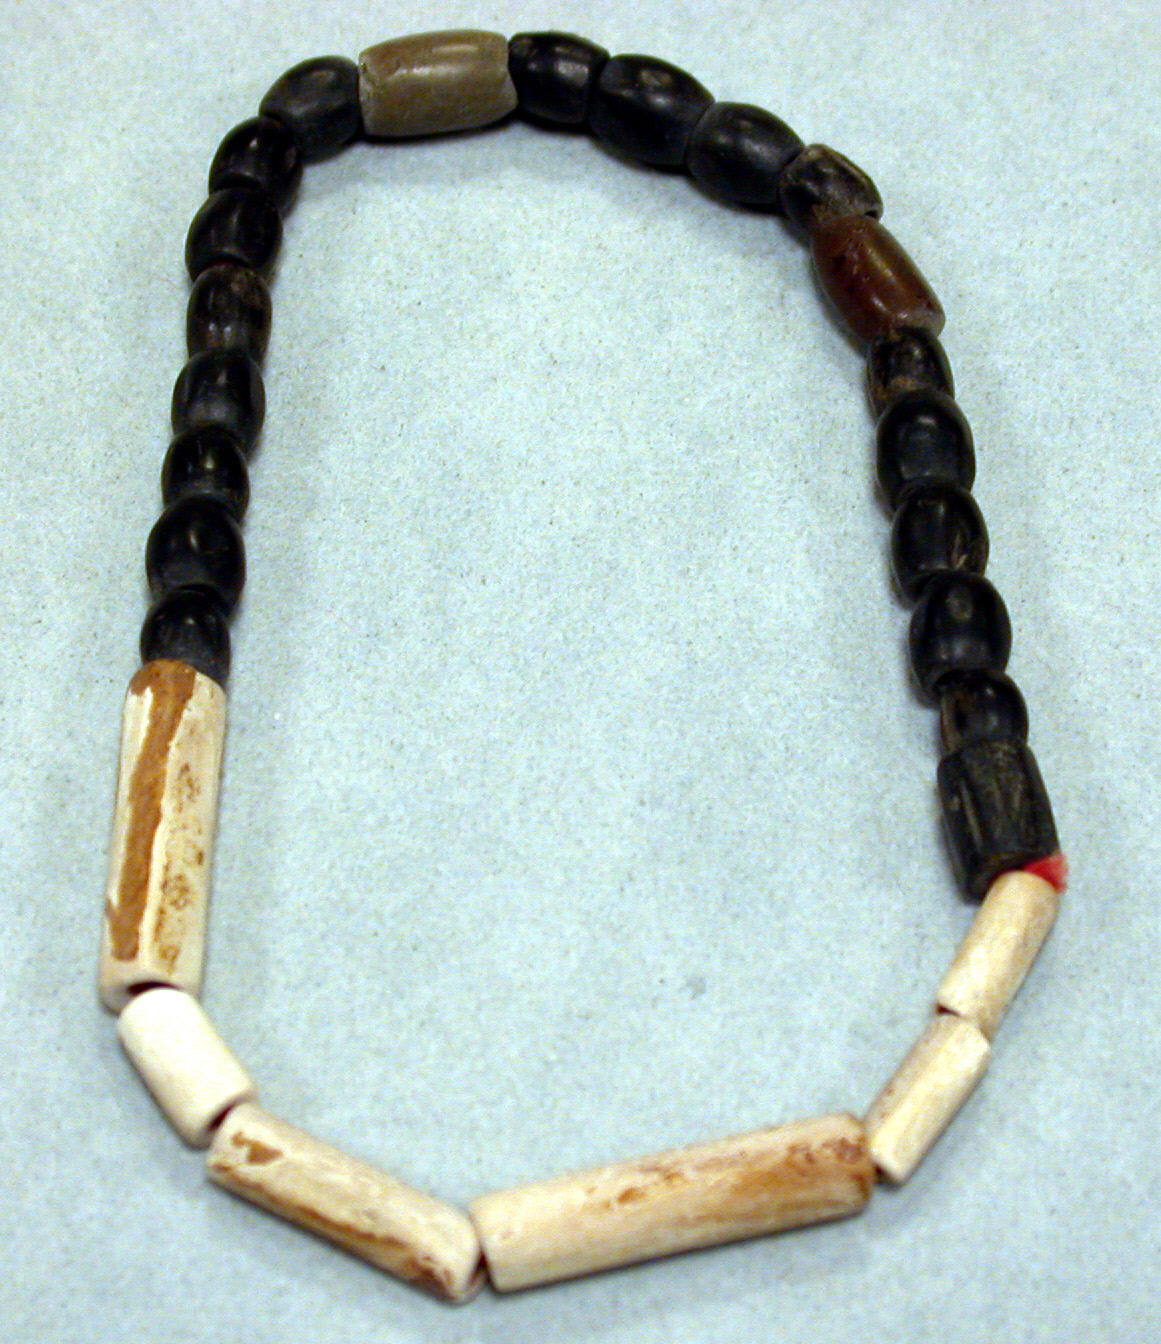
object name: bead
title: Necklace of Stone and Shell Beads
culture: peruvian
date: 1-1566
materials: shell, stone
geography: peru